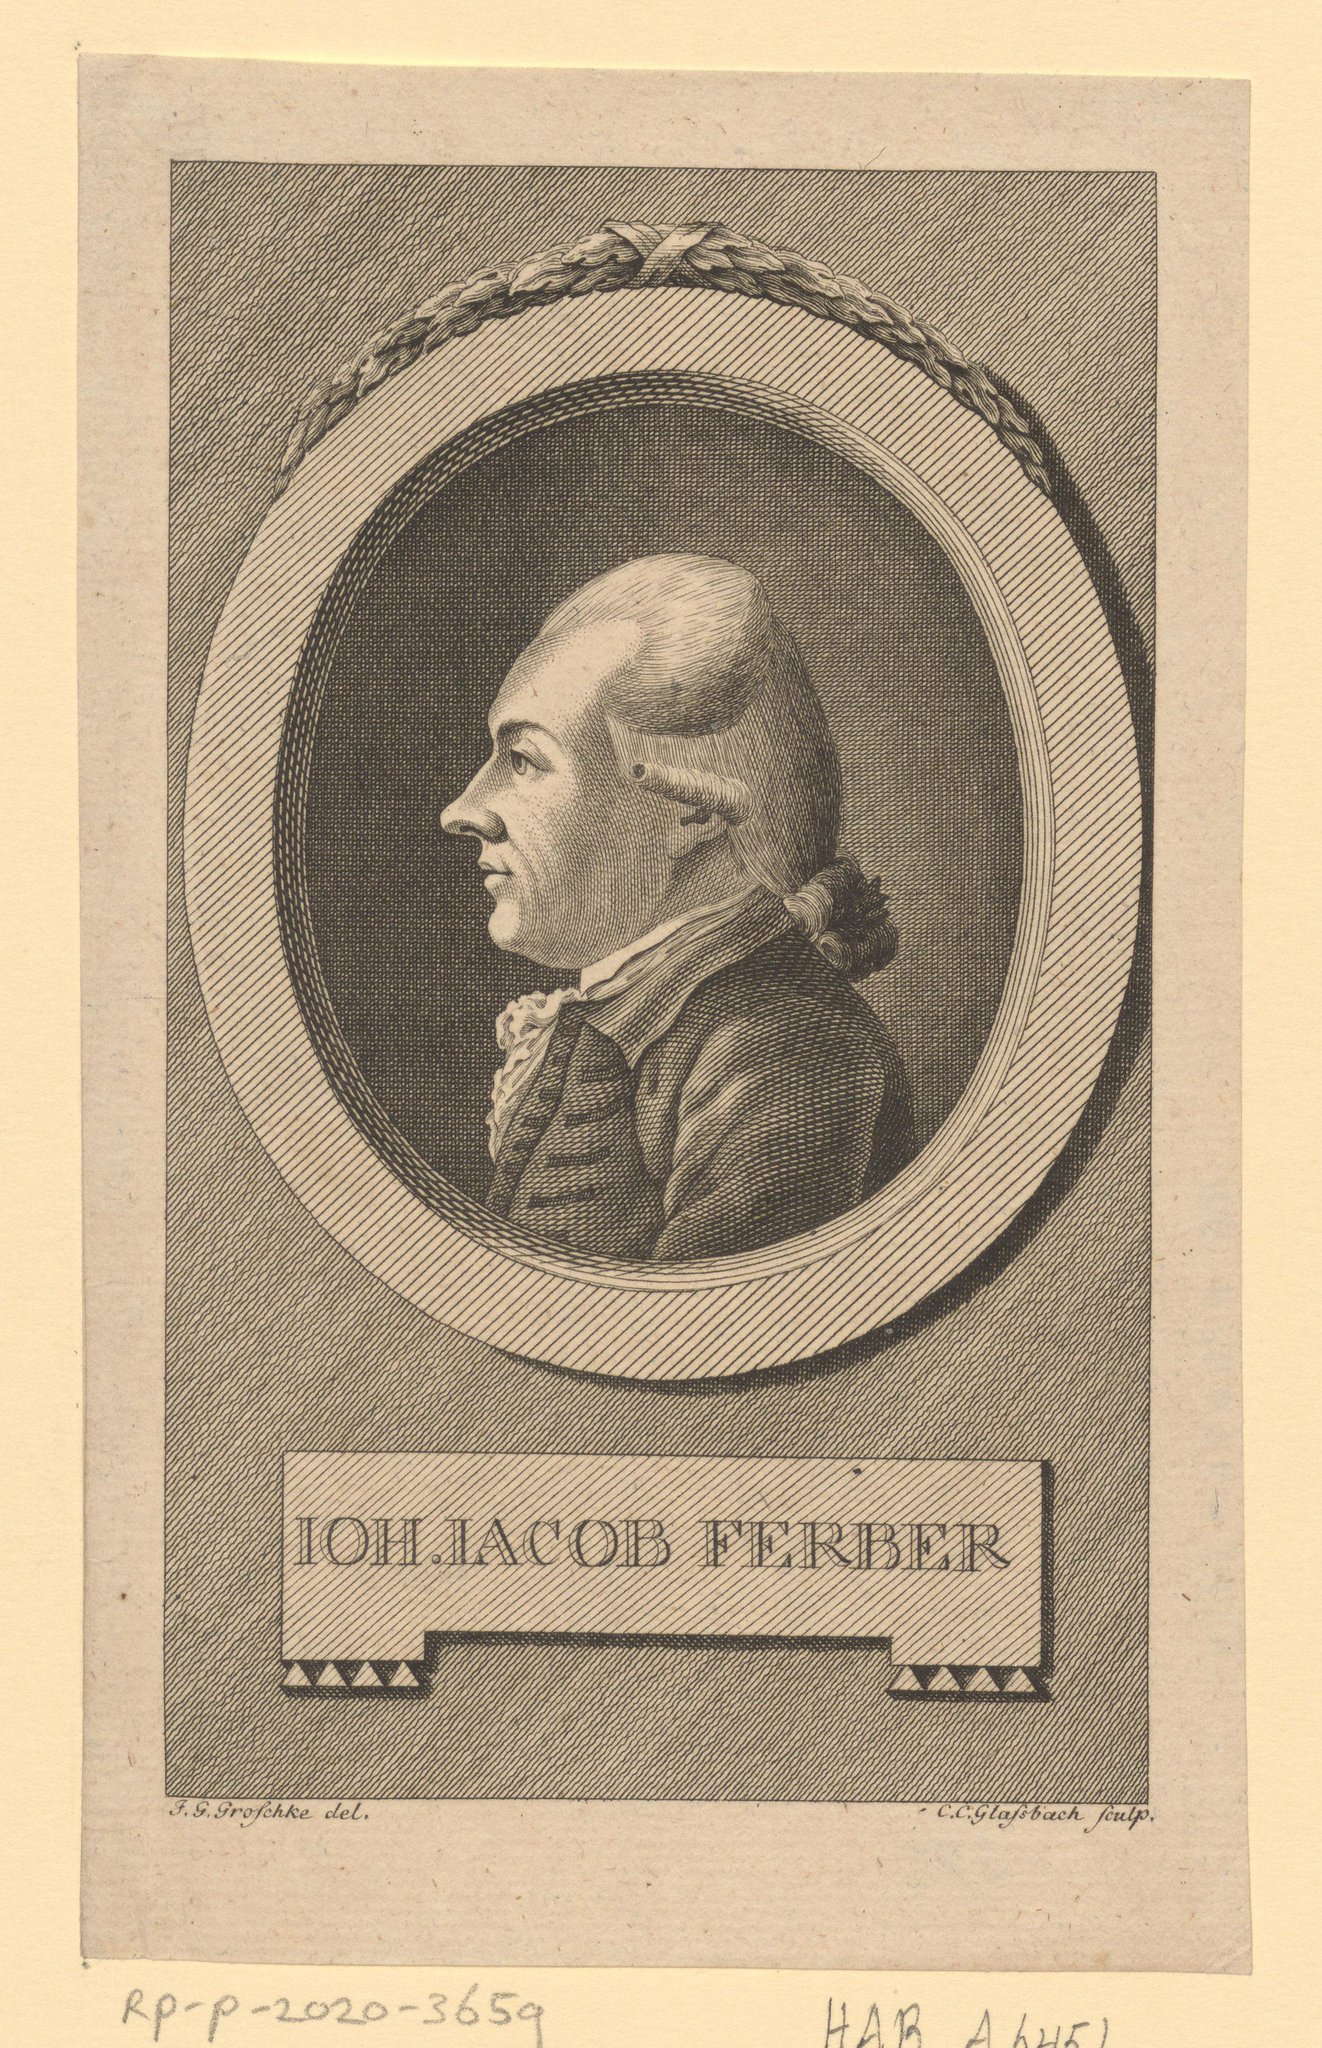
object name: print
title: Portret van Johann Jacob Ferber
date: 1780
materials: paper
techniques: engraving, etching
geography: germany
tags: historical persons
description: Prent waarschijnlijk uit: Allgemeine Deutsche Bibliothek, vol. 41, dl. 1, 1780.